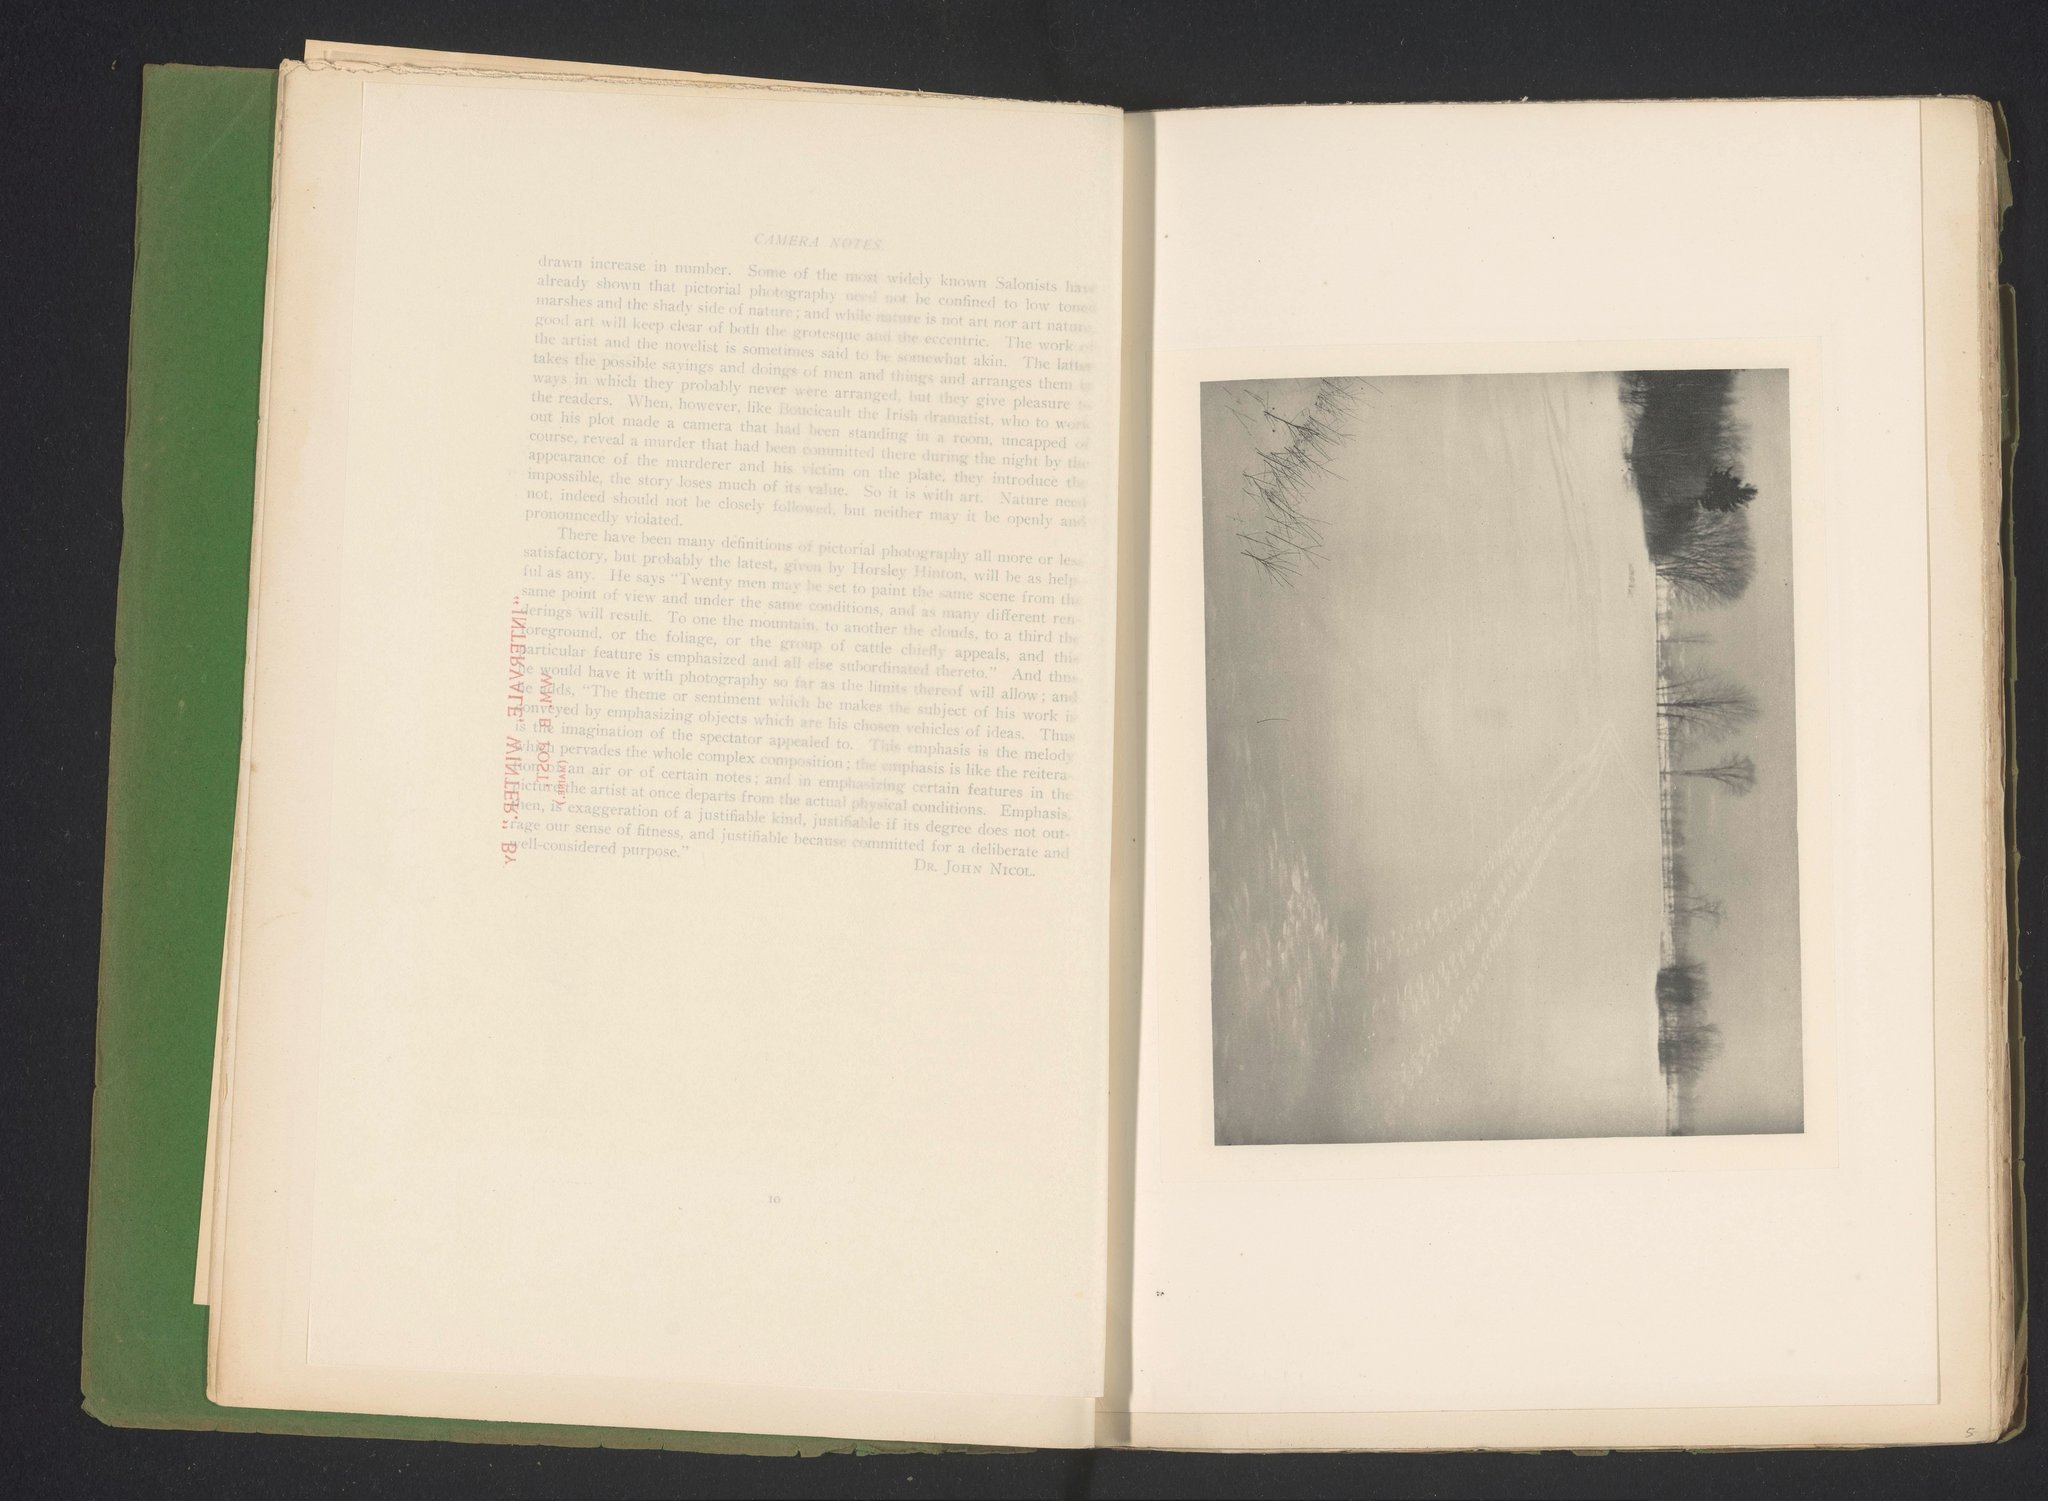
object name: page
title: Winterlandschap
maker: william boyd post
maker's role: fotograaf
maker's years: 1857-1921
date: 1896-1901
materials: paper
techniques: photoaquatint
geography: new york city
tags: frost, freezing weather, landscapes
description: Prent tegenover pagina 10, achter semi-transparante omslag.